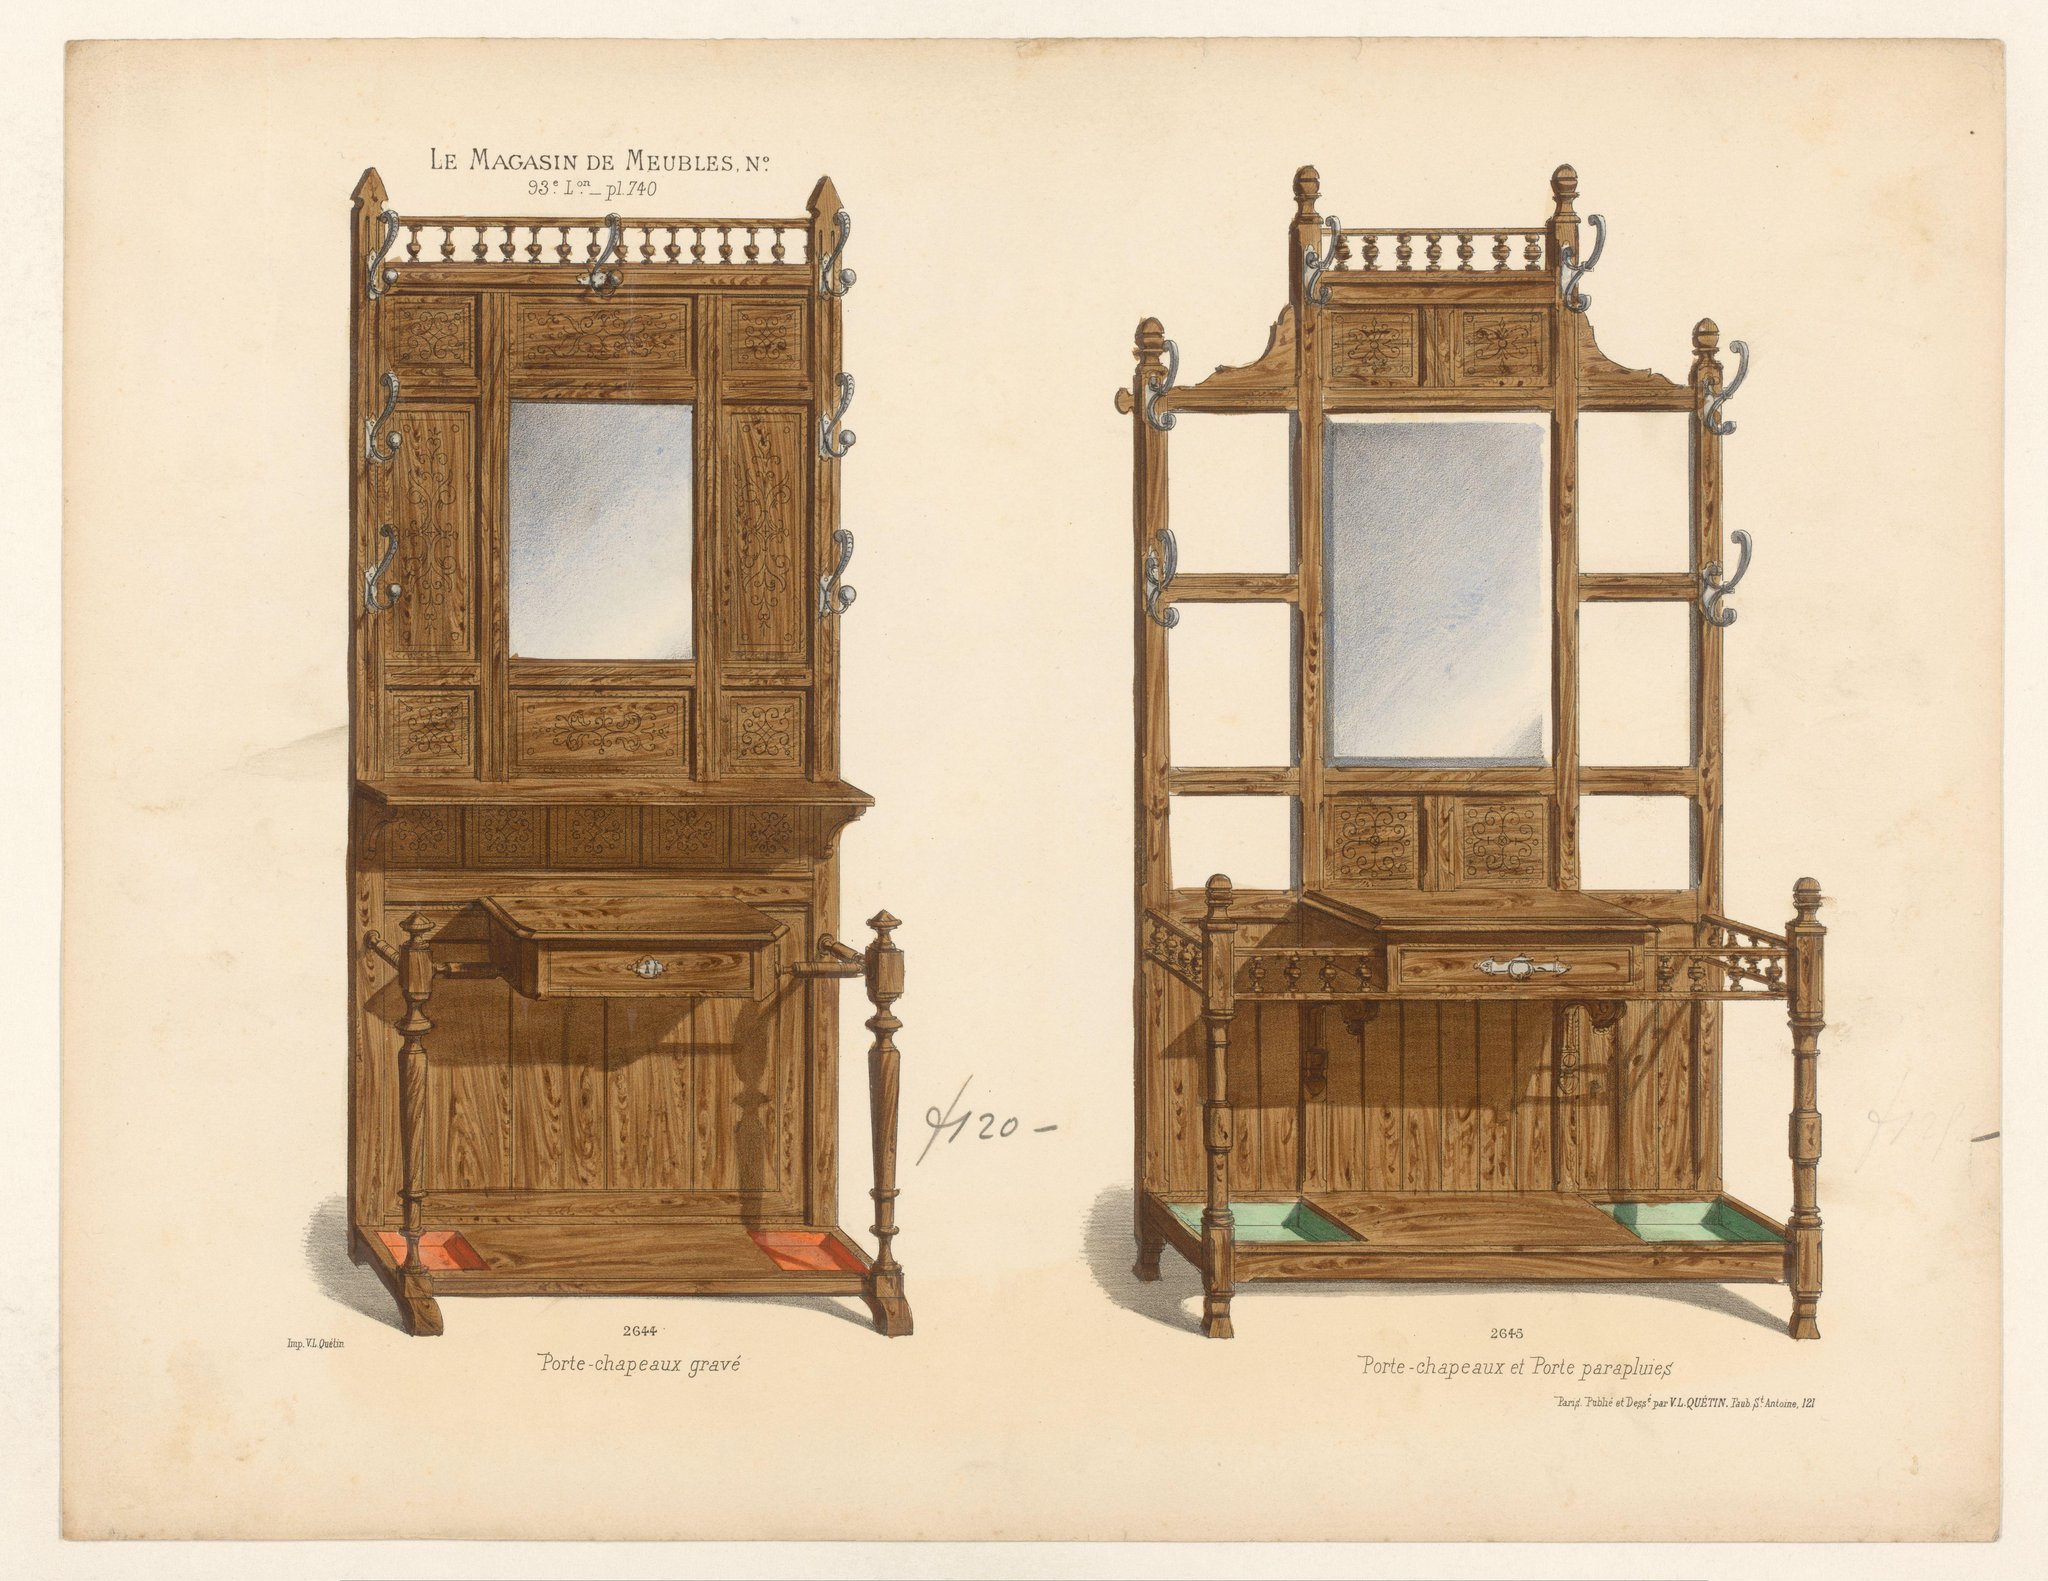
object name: print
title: Porte-chapeaux gravé / Porte-chapeaux et Porte parapluies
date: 1878-1904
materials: paper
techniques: hand coloring, lithograph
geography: paris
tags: mirror, hanging clothes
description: Twee meubels met een spiegel, kapstokken en paraplustandaards. Prent uit 93e Livraison.